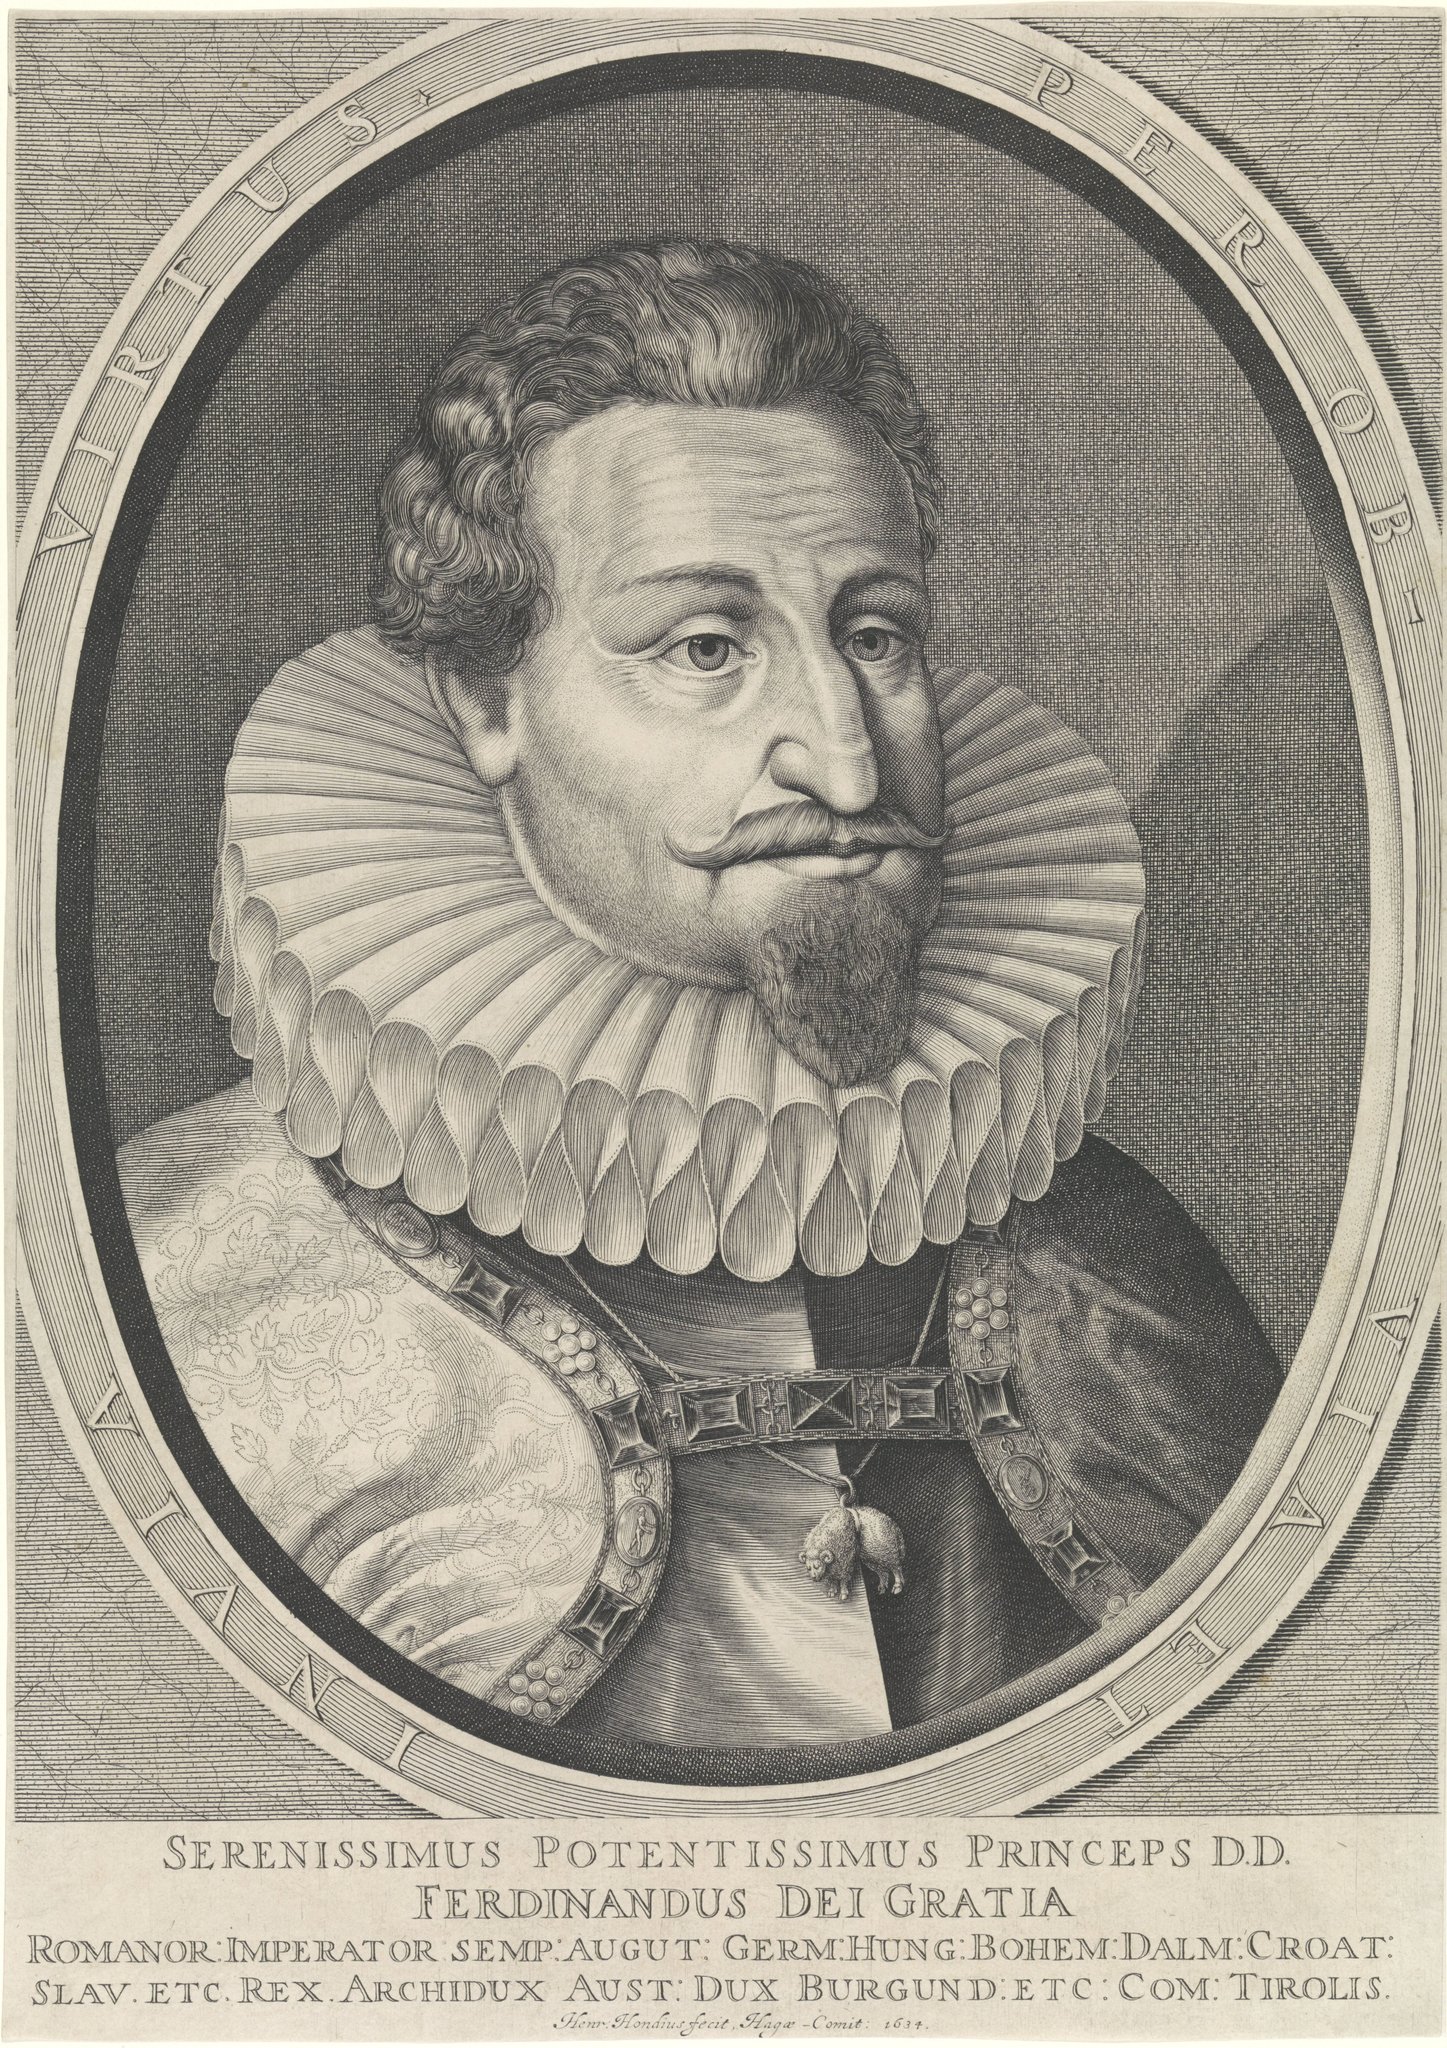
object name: print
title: Portret van keizer Ferdinand I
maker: hendrick hondius (i)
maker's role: draughtsman, print maker, publisher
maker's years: 1573-1650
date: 1634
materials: paper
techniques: engraving, etching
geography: the hague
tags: vienna, ferdinand i van habsburg (duits keizer), knighthood order of the golden fleece - insignia of a knighthood order, e.g.: badge, chain (with name of order)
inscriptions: collector's mark: Lugt 2228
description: Buste naar rechts van Ferdinand I van Habsburg, Duits keizer met om zijn hals het teken van de Orde van het Gulden Vlies in een ovale omlijsting met randschrift in het Latijn. Onder het portret vier regels in het Latijn.